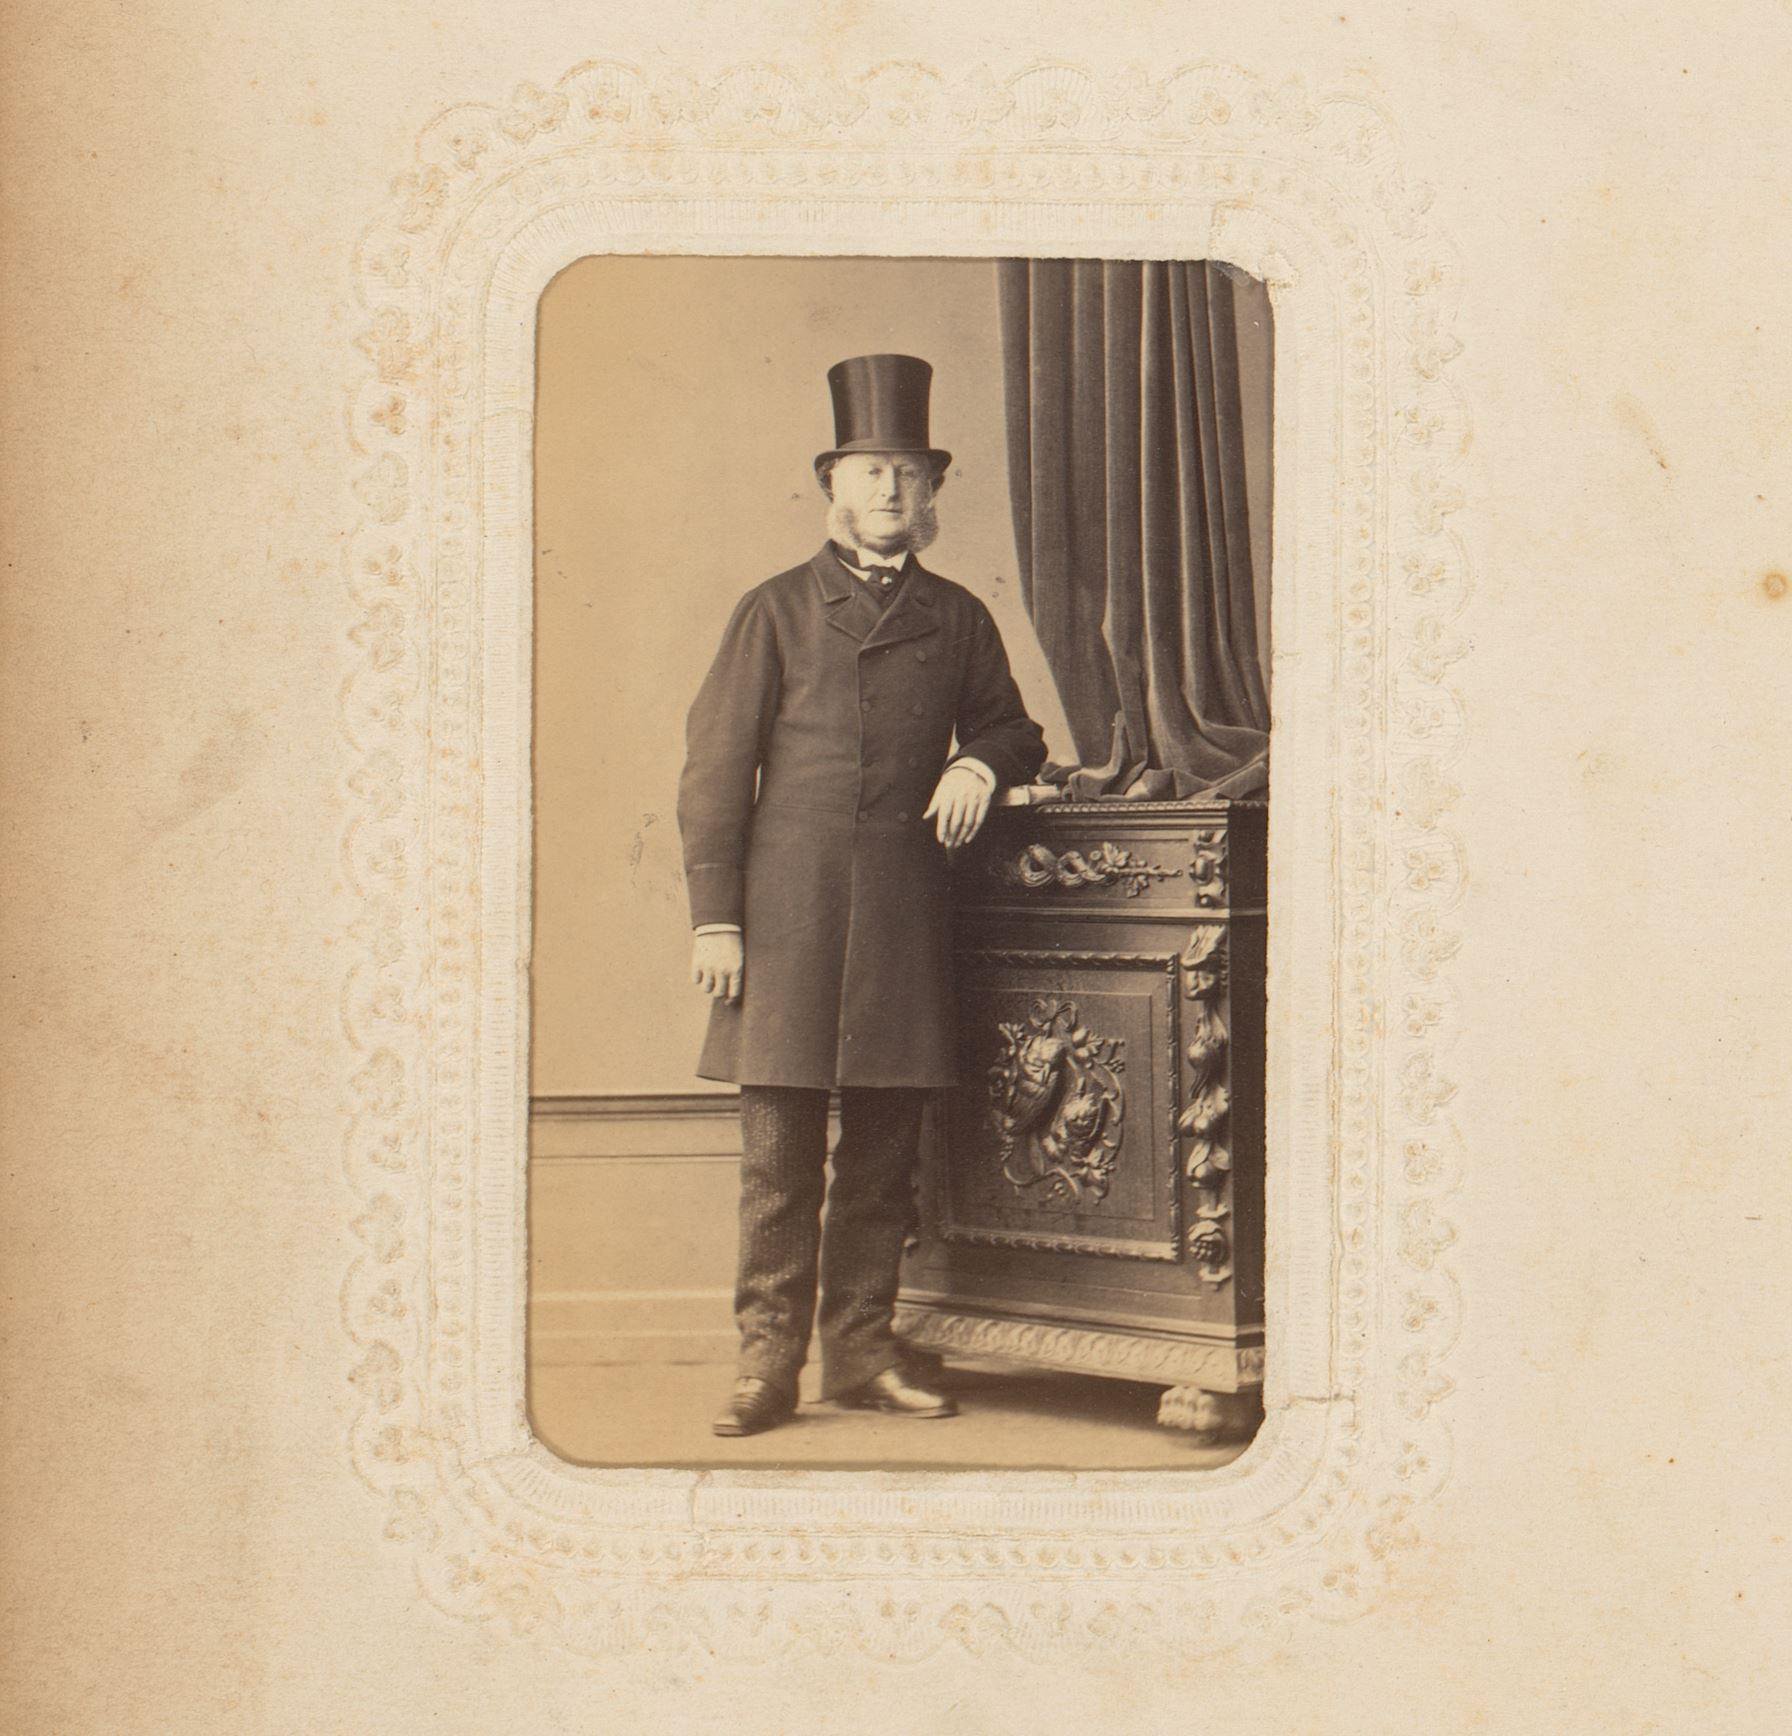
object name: album leaf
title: Portret van een staande man met hoge hoed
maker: Anonymous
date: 1860-1890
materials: cardboard, photographic support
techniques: albumen print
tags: historical persons, head-gear: top hat